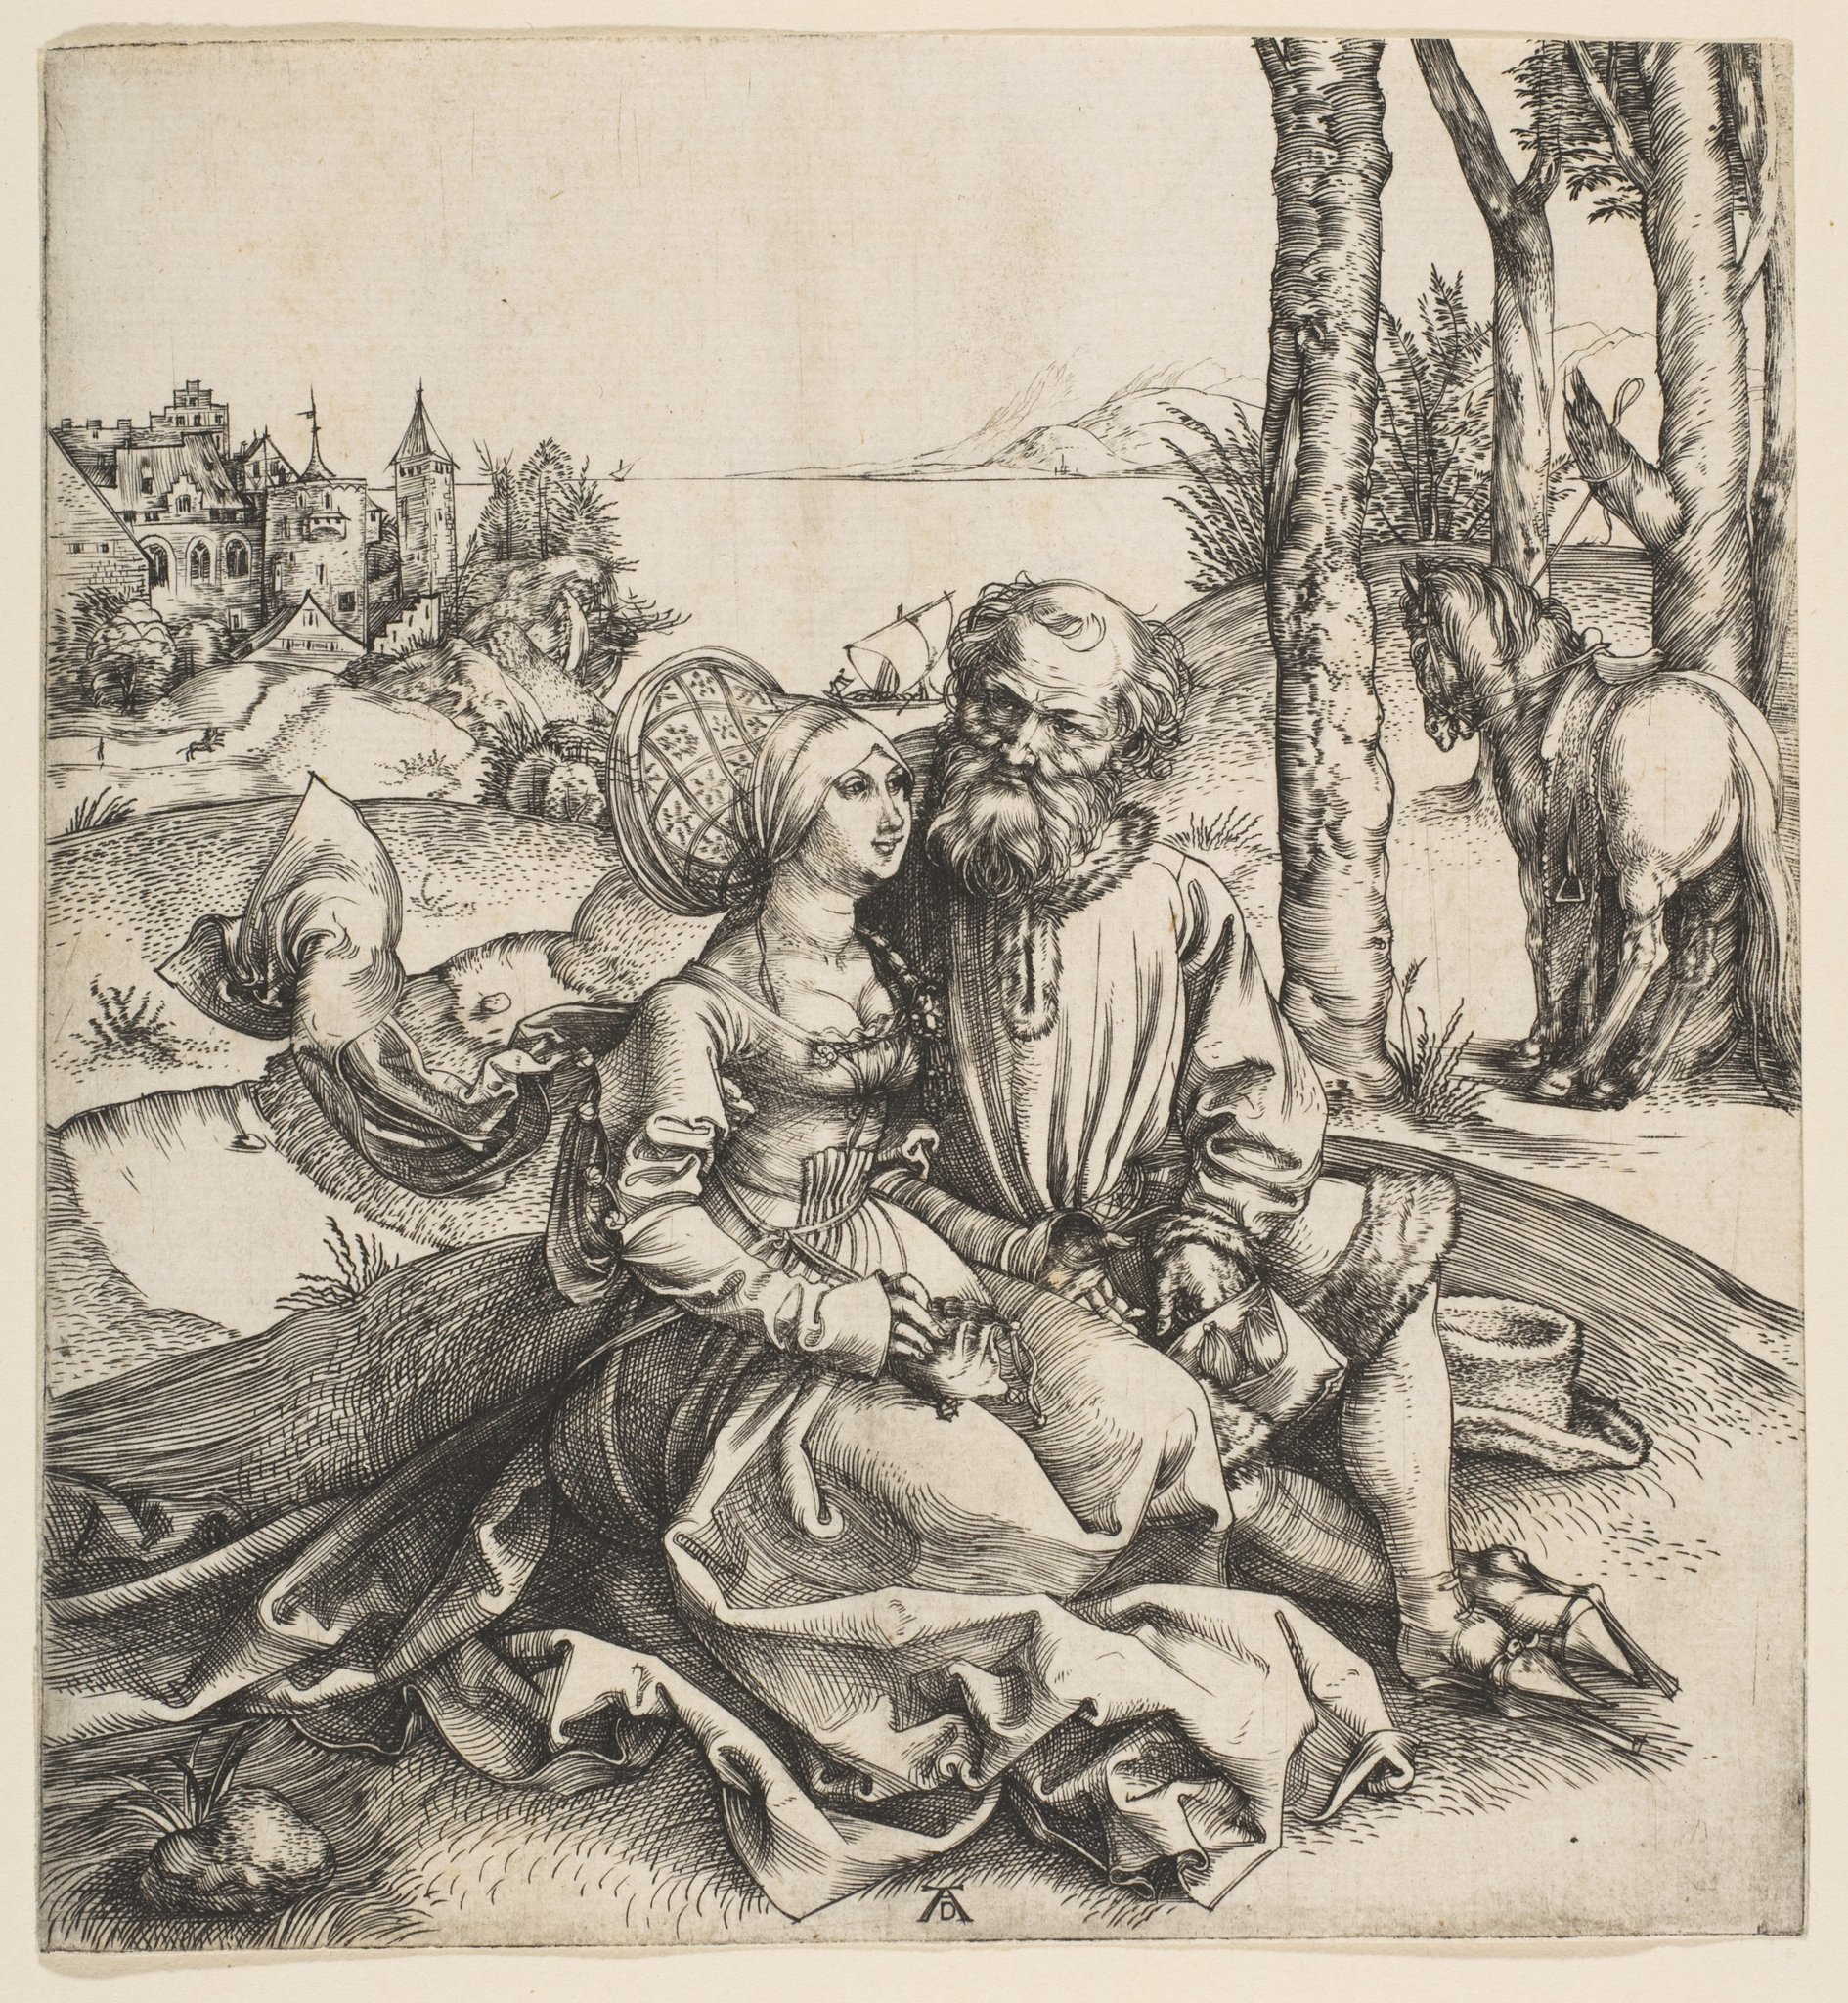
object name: print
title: The Ill-Assorted Couple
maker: albrecht dürer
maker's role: artist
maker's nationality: german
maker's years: 1471-1528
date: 1495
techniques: engraving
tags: couples,men,women,horses